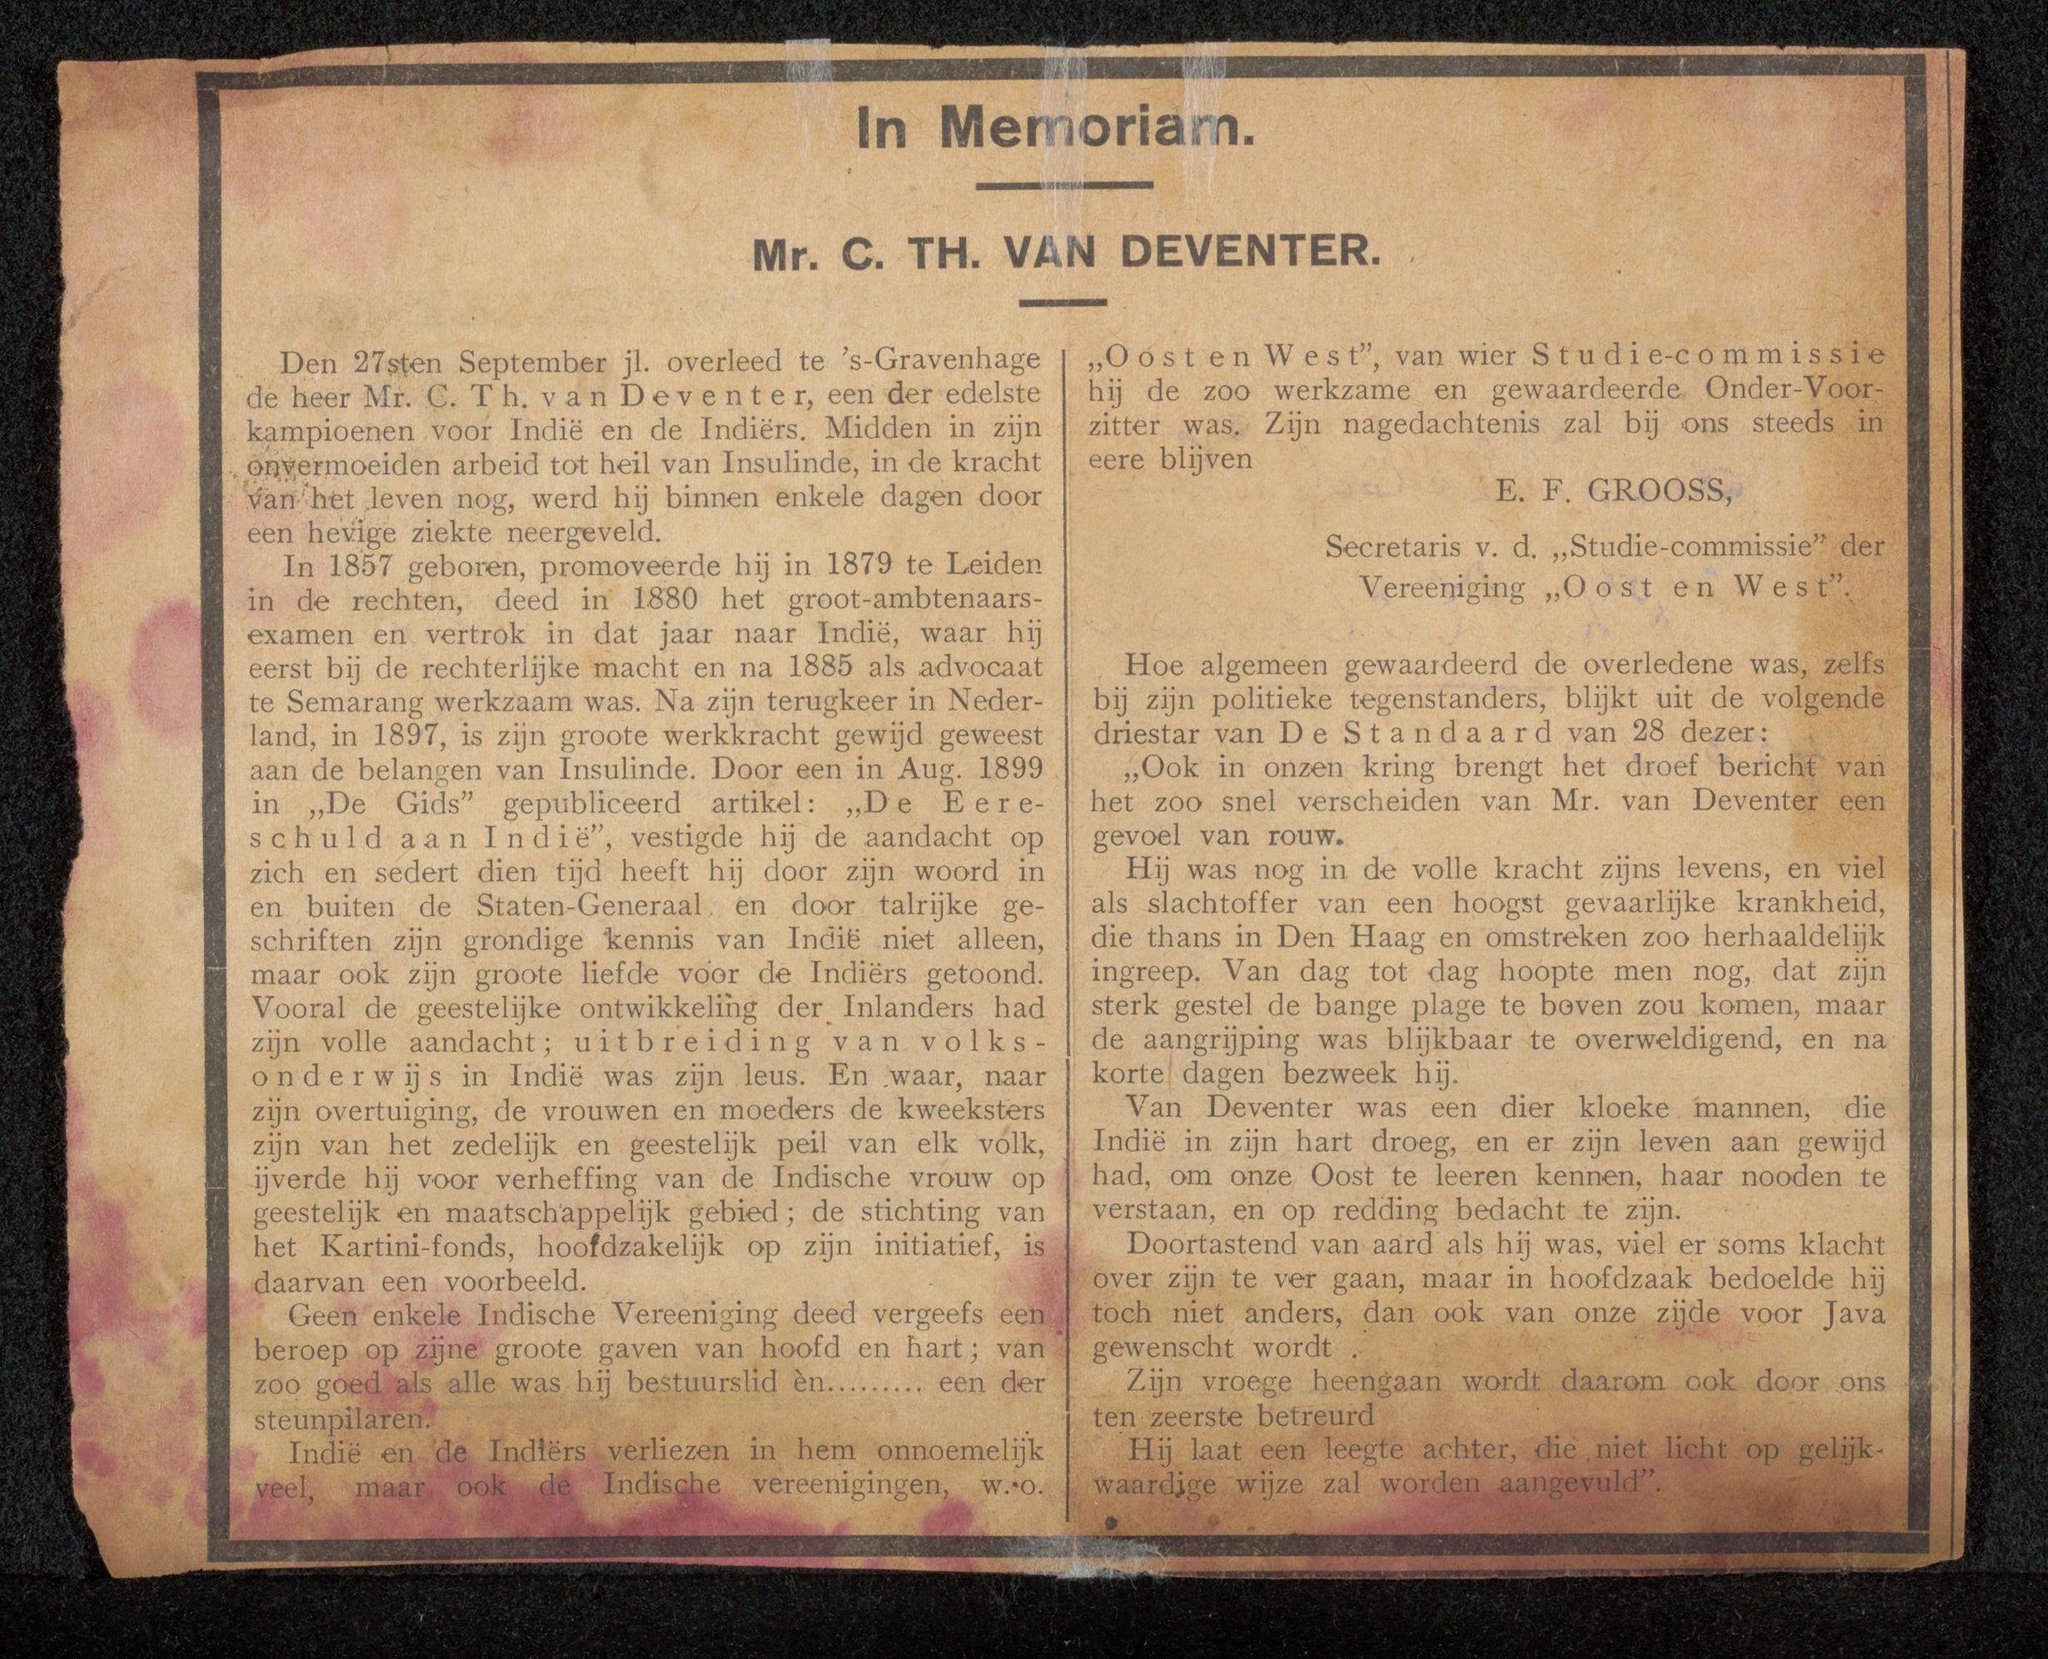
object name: newspaper clipping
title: Krantenknipsel uit archief Philip Zilcken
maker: e.f. grooss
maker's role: secretaris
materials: paper, ink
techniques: printing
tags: dordrecht, conrad th. van deventer, painter, draughtsman, philip zilcken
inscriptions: collector's mark: ‘RPK’